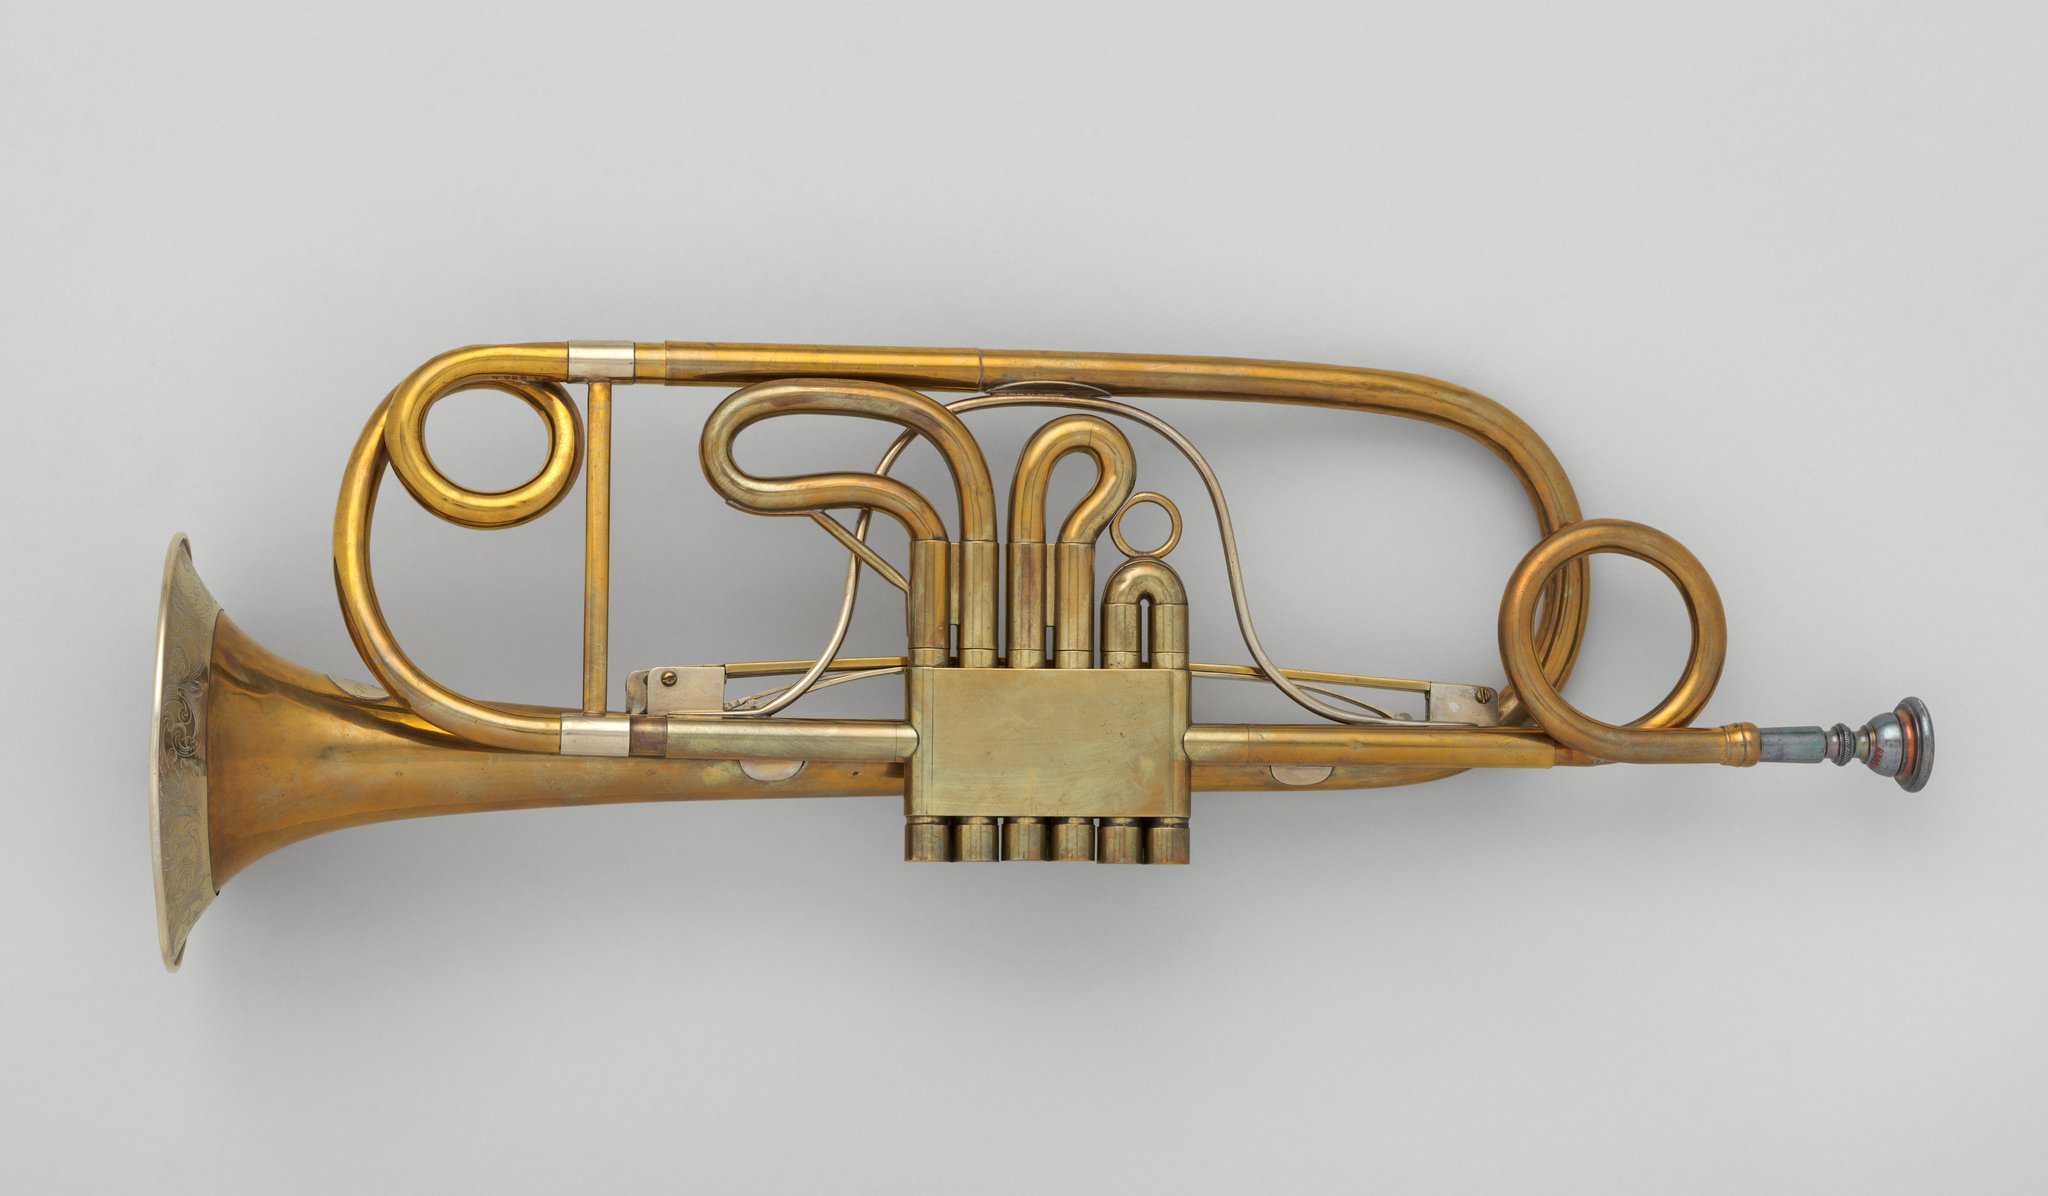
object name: valve trumpet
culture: american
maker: elbridge g. wright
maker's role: maker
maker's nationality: american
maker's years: 1839-1871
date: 1845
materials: brass, nickel, silver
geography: united states